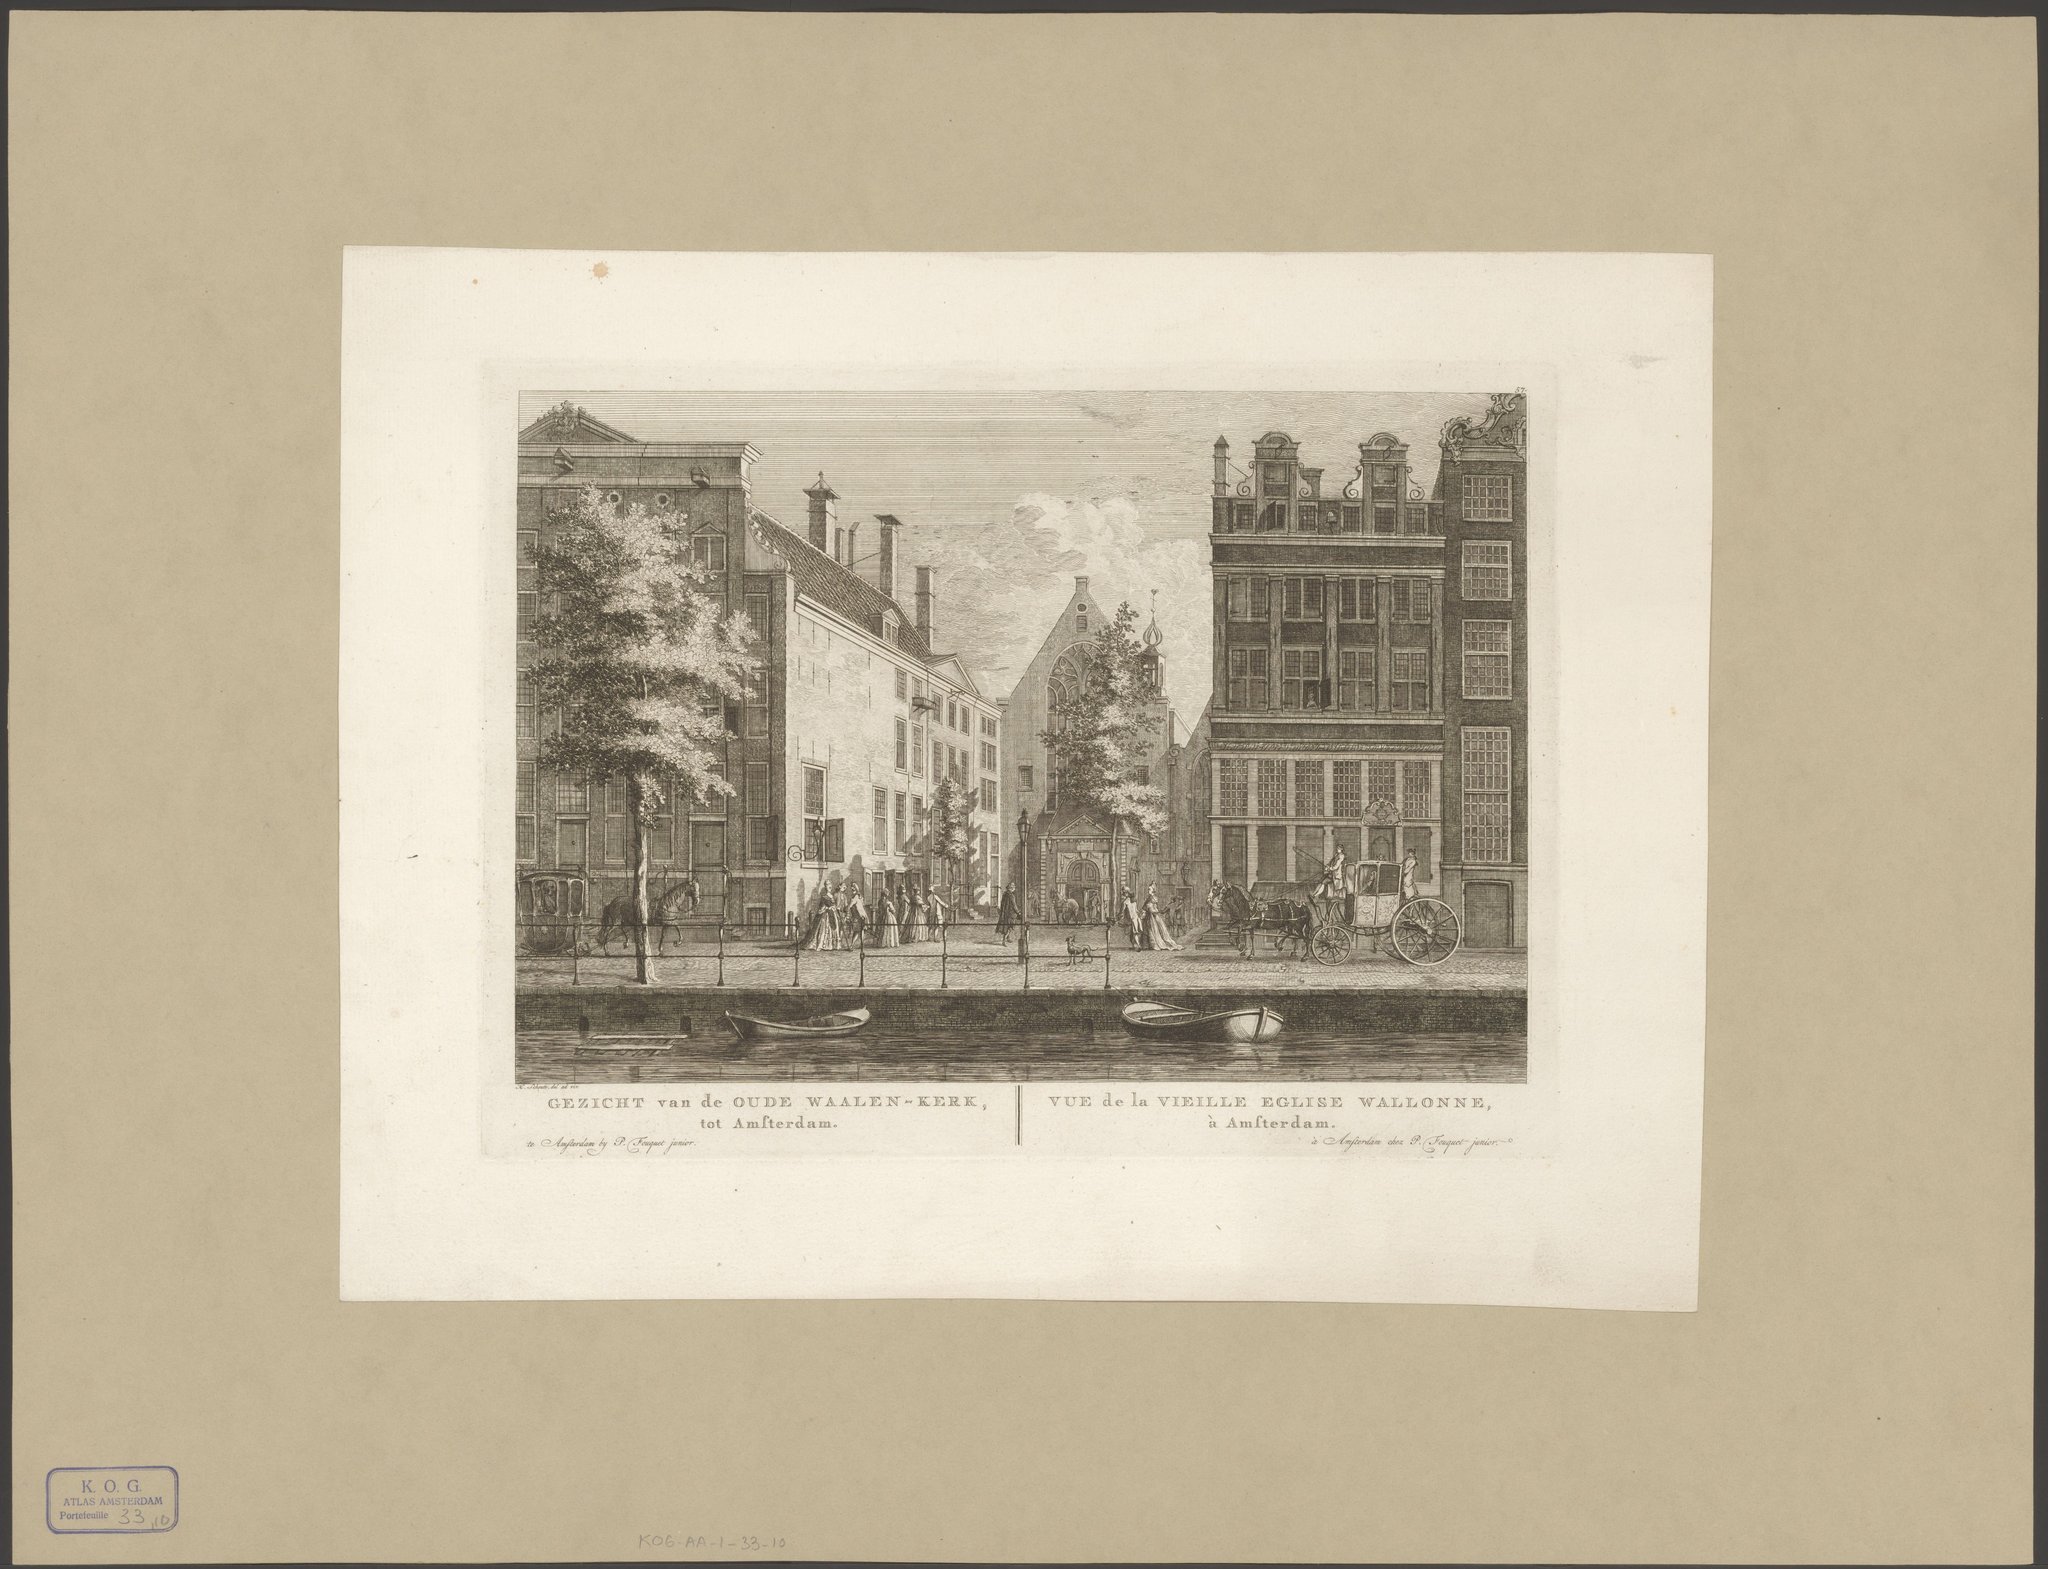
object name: print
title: Gezicht van de Oude Waalen-Kerk, tot Amsterdam / Vue de la Vieille Eglise Wallonne, à Amsterdam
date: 1770-1783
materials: paper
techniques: engraving, etching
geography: amsterdam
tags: church (exterior), rowing-boat, canoe, etc., four-wheeled vehicle drawn by two animals, square, place, circus, etc. (+ city(-scape) with figures, staffage), canals, waters (in city) (+ city(-scape) with figures, staffage)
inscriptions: collector's mark: Lugt 1641b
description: Vanaf 1760 gaf Pierre Fouquet stadsgezichten van Amsterdam naar tekeningen van verschillende kunstenaars uit. Deze prenten werden aanvankelijk los verkocht. Later werden ze samengebonden verkocht in verschillende volgordes en aantallen in: (1). Afbeeldingen van de wyd-vermaarde koopstad Amsterdam benevens des zelvs voornaamste gebouwen en gezigten alle naar het leeven getekend / Receuil des edifices les plus considerables et des plus belles vues, de la fameuse ville d'Amsterdam, dessinées d'après nature. Amsterdam: Pierre Fouquet, 1778-1783. Deze 'uitgave' bestond waarschijnlijk alleen uit een titelblad en inhoudsopgave van de tot dusver 100 uitgegeven prenten, die de koper zelf aan zijn of haar reeds verzamelde prenten kon toevoegen. De hoeveelheid en volgorde van prenten verzameld onder deze titel verschilt dus sterk. (2). Nieuwe atlas, van de voornaamste gebouwen en gezigten der stad Amsterdam, met derzelver beknopte beschryvingen. 2 dln. Amsterdam: Daniël Jean Changuion en Petrus den Hengst [in opdracht van Pierre Fouquet], 1783. Ook werden er door verschillende uitgevers tussen 1788 (Amsterdam: Petrus Conradi) en 1805 (Amsterdam: Evert Maaskamp) heruitgaven gepubliceerd.